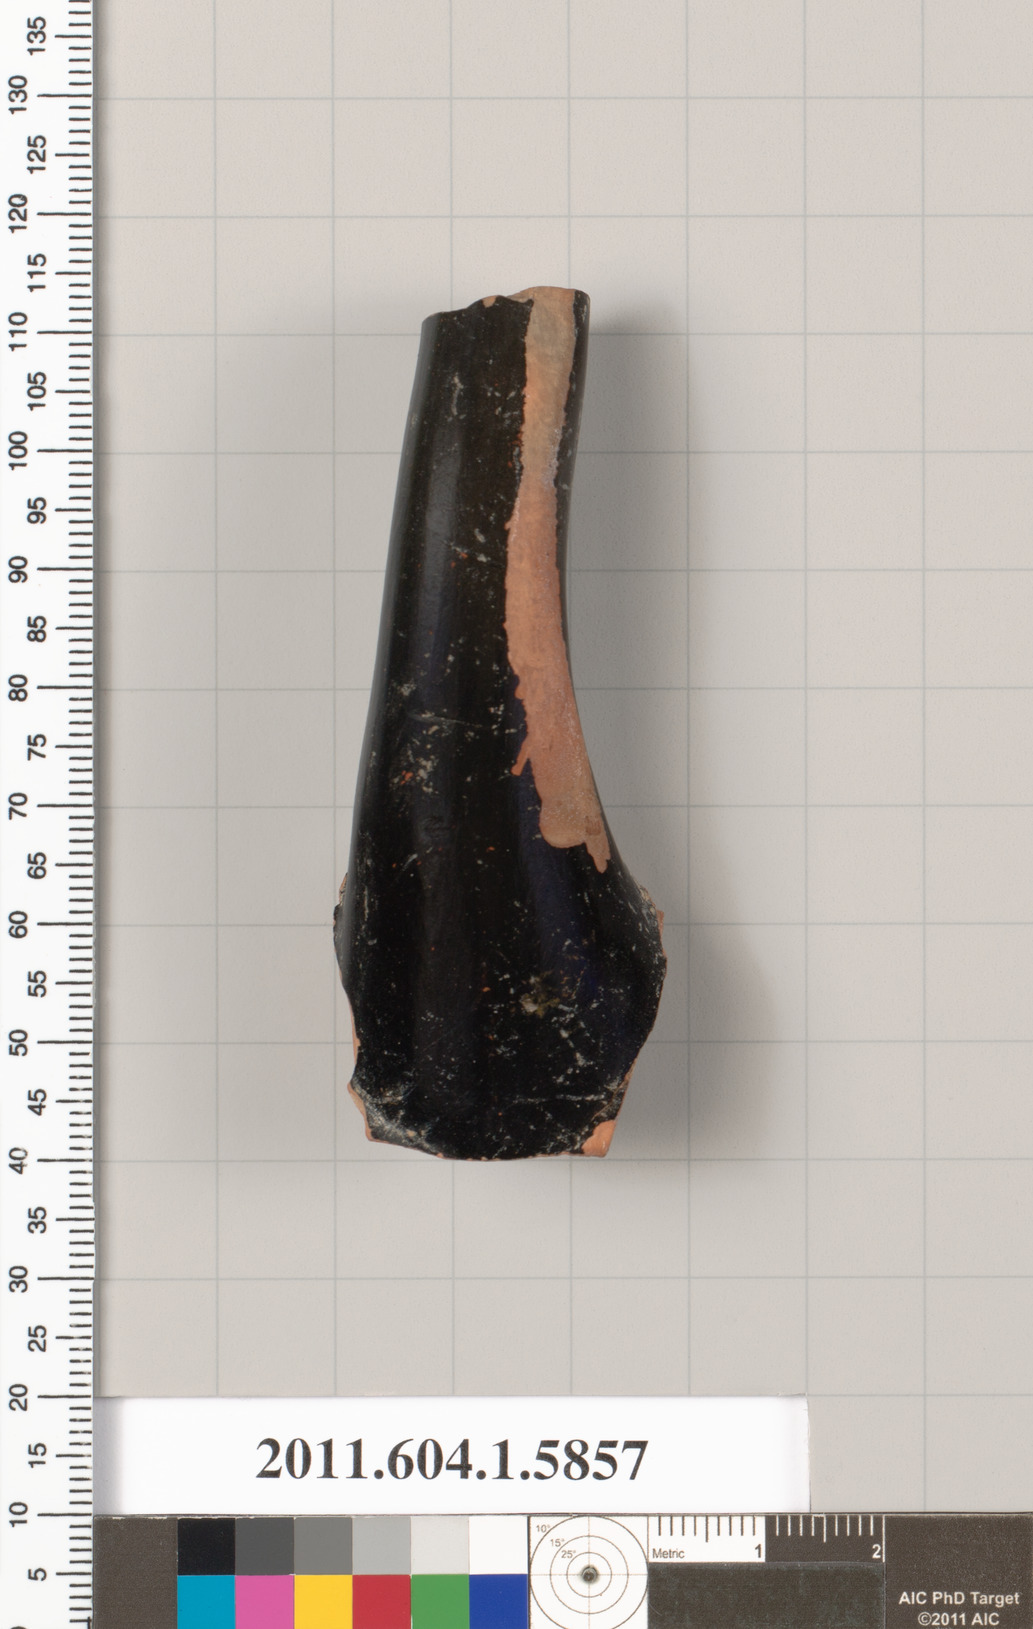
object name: kylix fragment, eye cup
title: Terracotta fragment of a kylix: eye-cup (drinking cup)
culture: greek, attic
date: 433-567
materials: terracotta